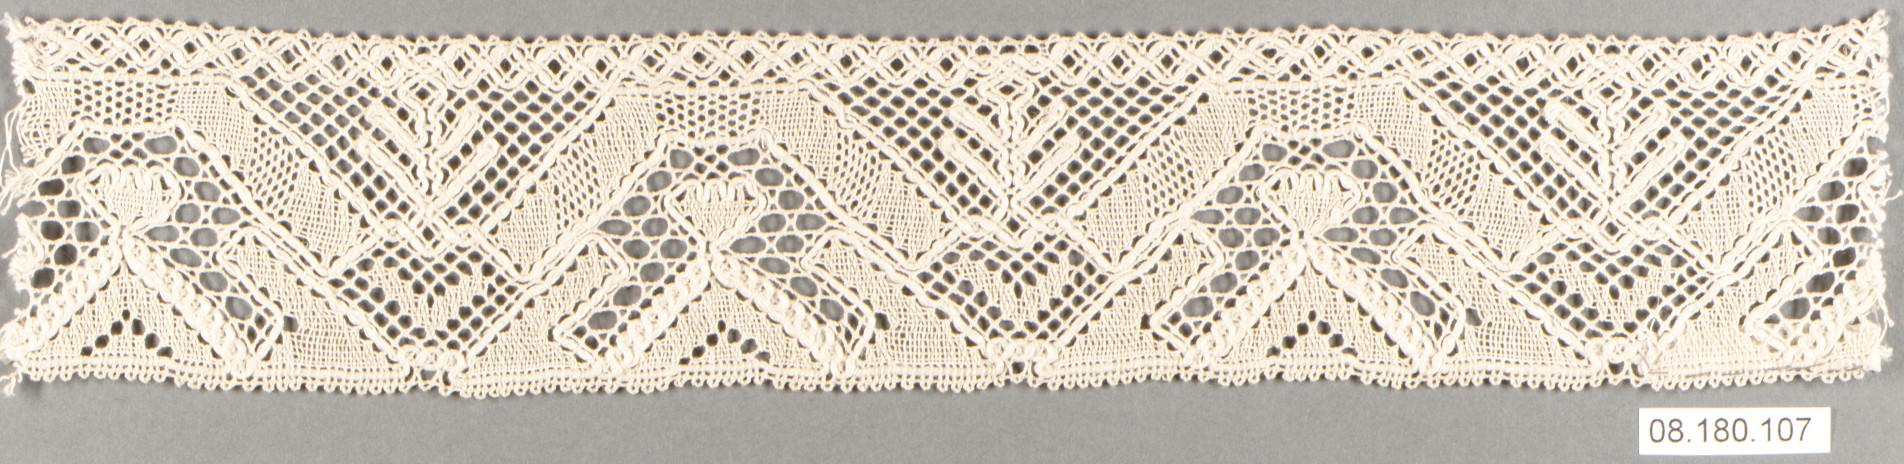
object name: fragment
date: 1801-1900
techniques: lace